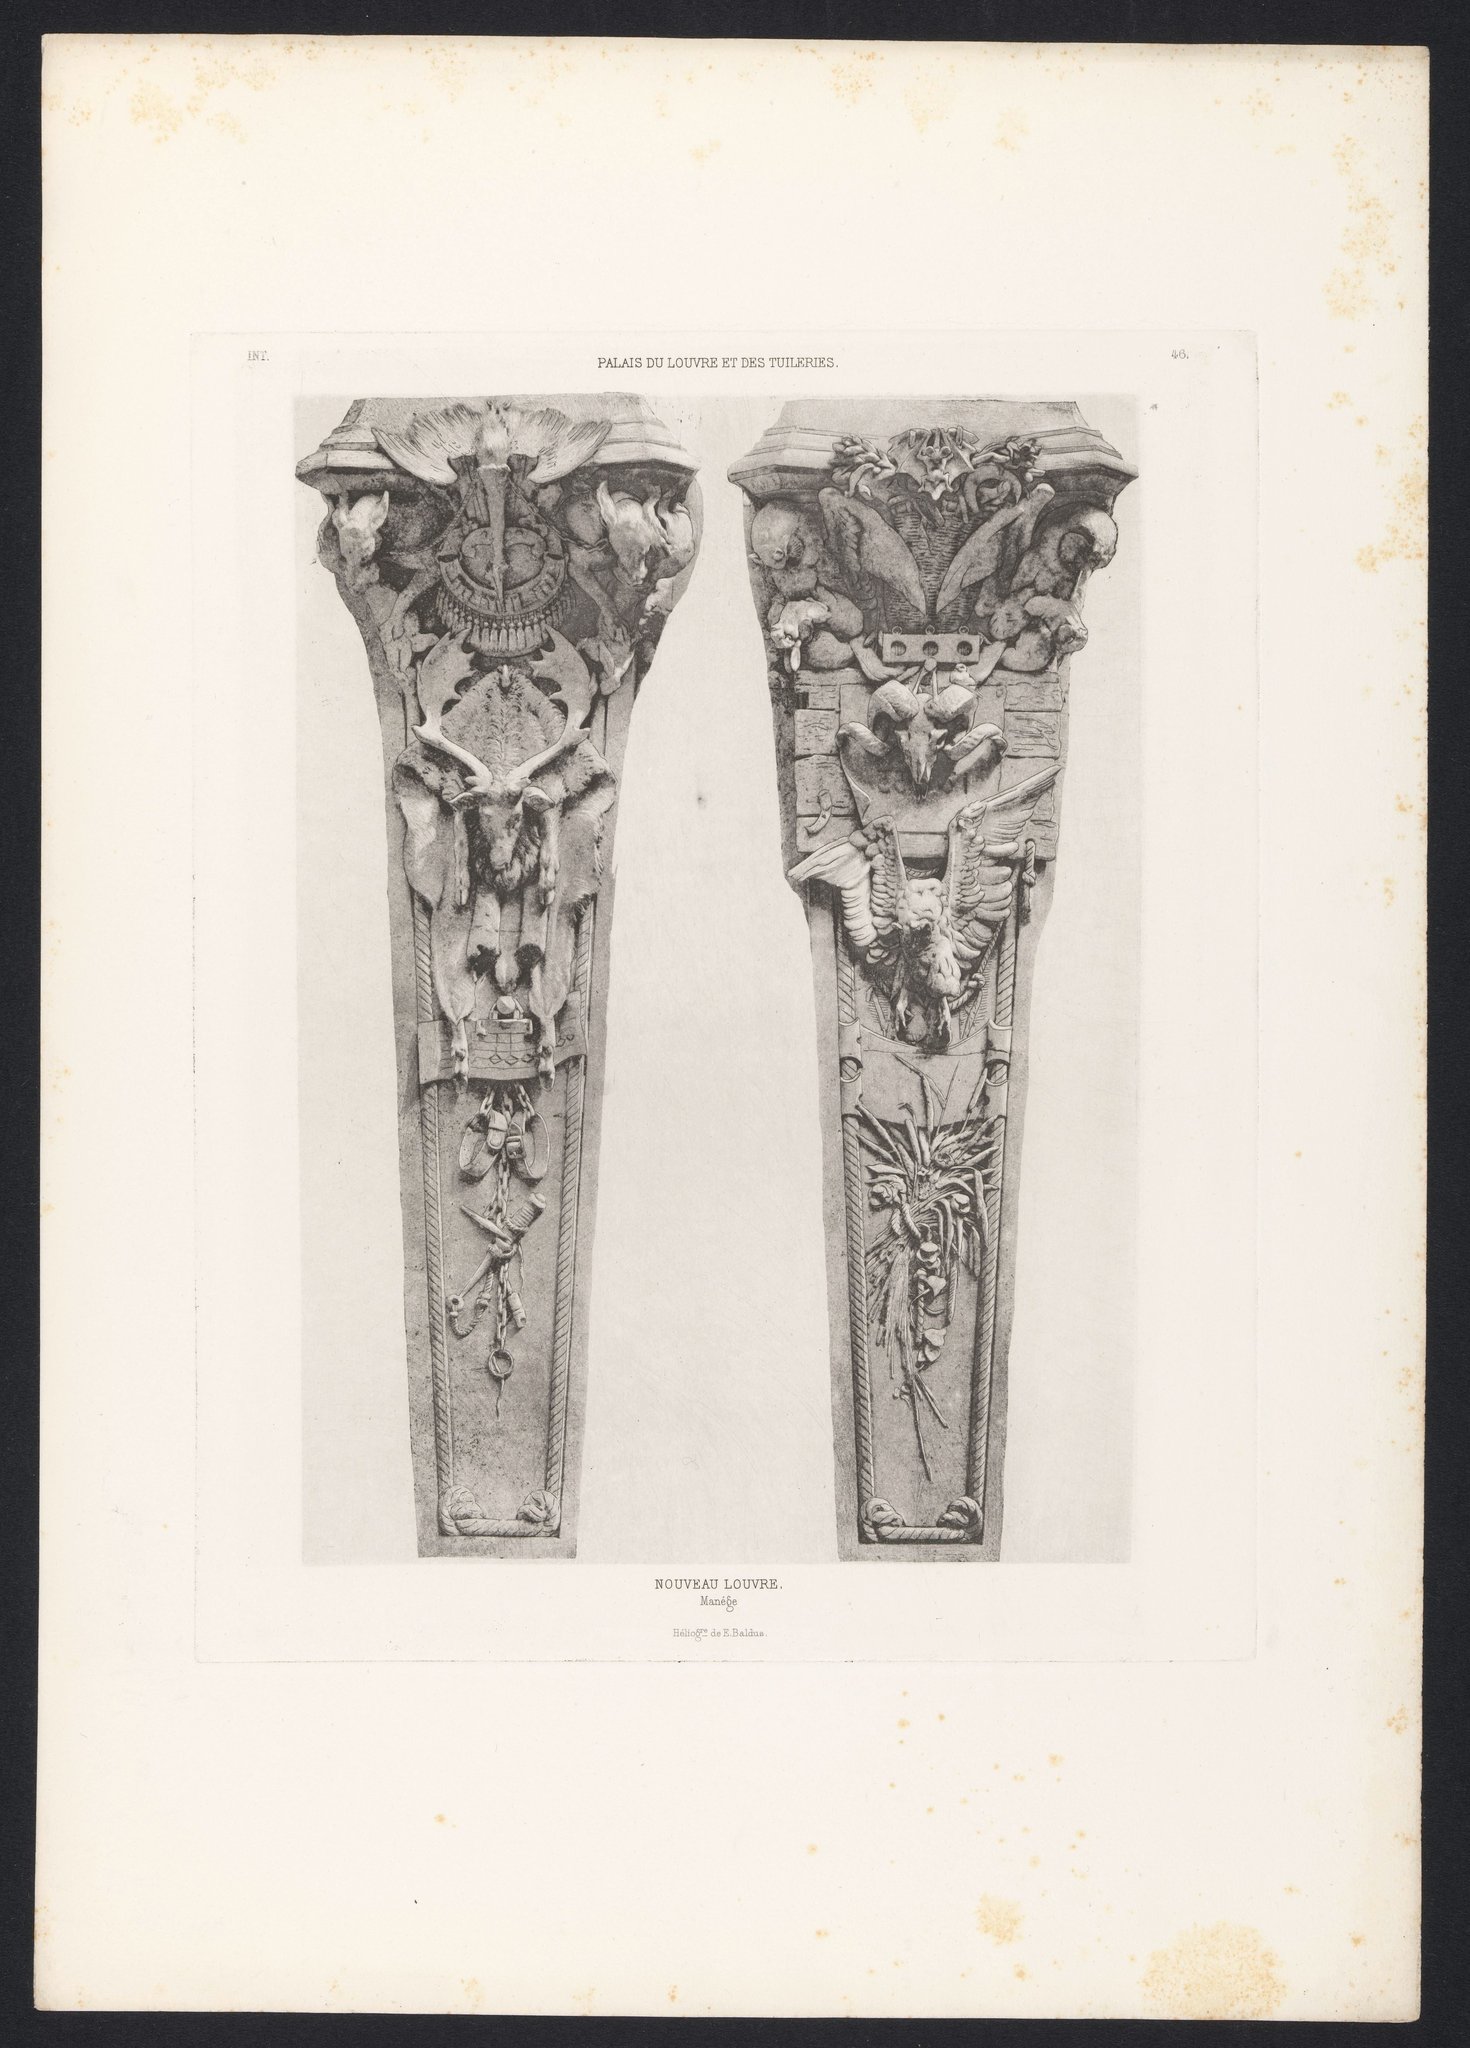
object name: photomechanical print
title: Fotoreproductie van een tekening, voorstellende twee pilasters met dierornamenten voor de Salle du Manège in het Palais du Louvre te Parijs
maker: édouard denis baldus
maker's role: fotograaf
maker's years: 1813-1889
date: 1865-1870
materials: paper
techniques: photoaquatint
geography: france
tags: capital (~ column, pillar)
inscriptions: number: ‘Int. 46.’